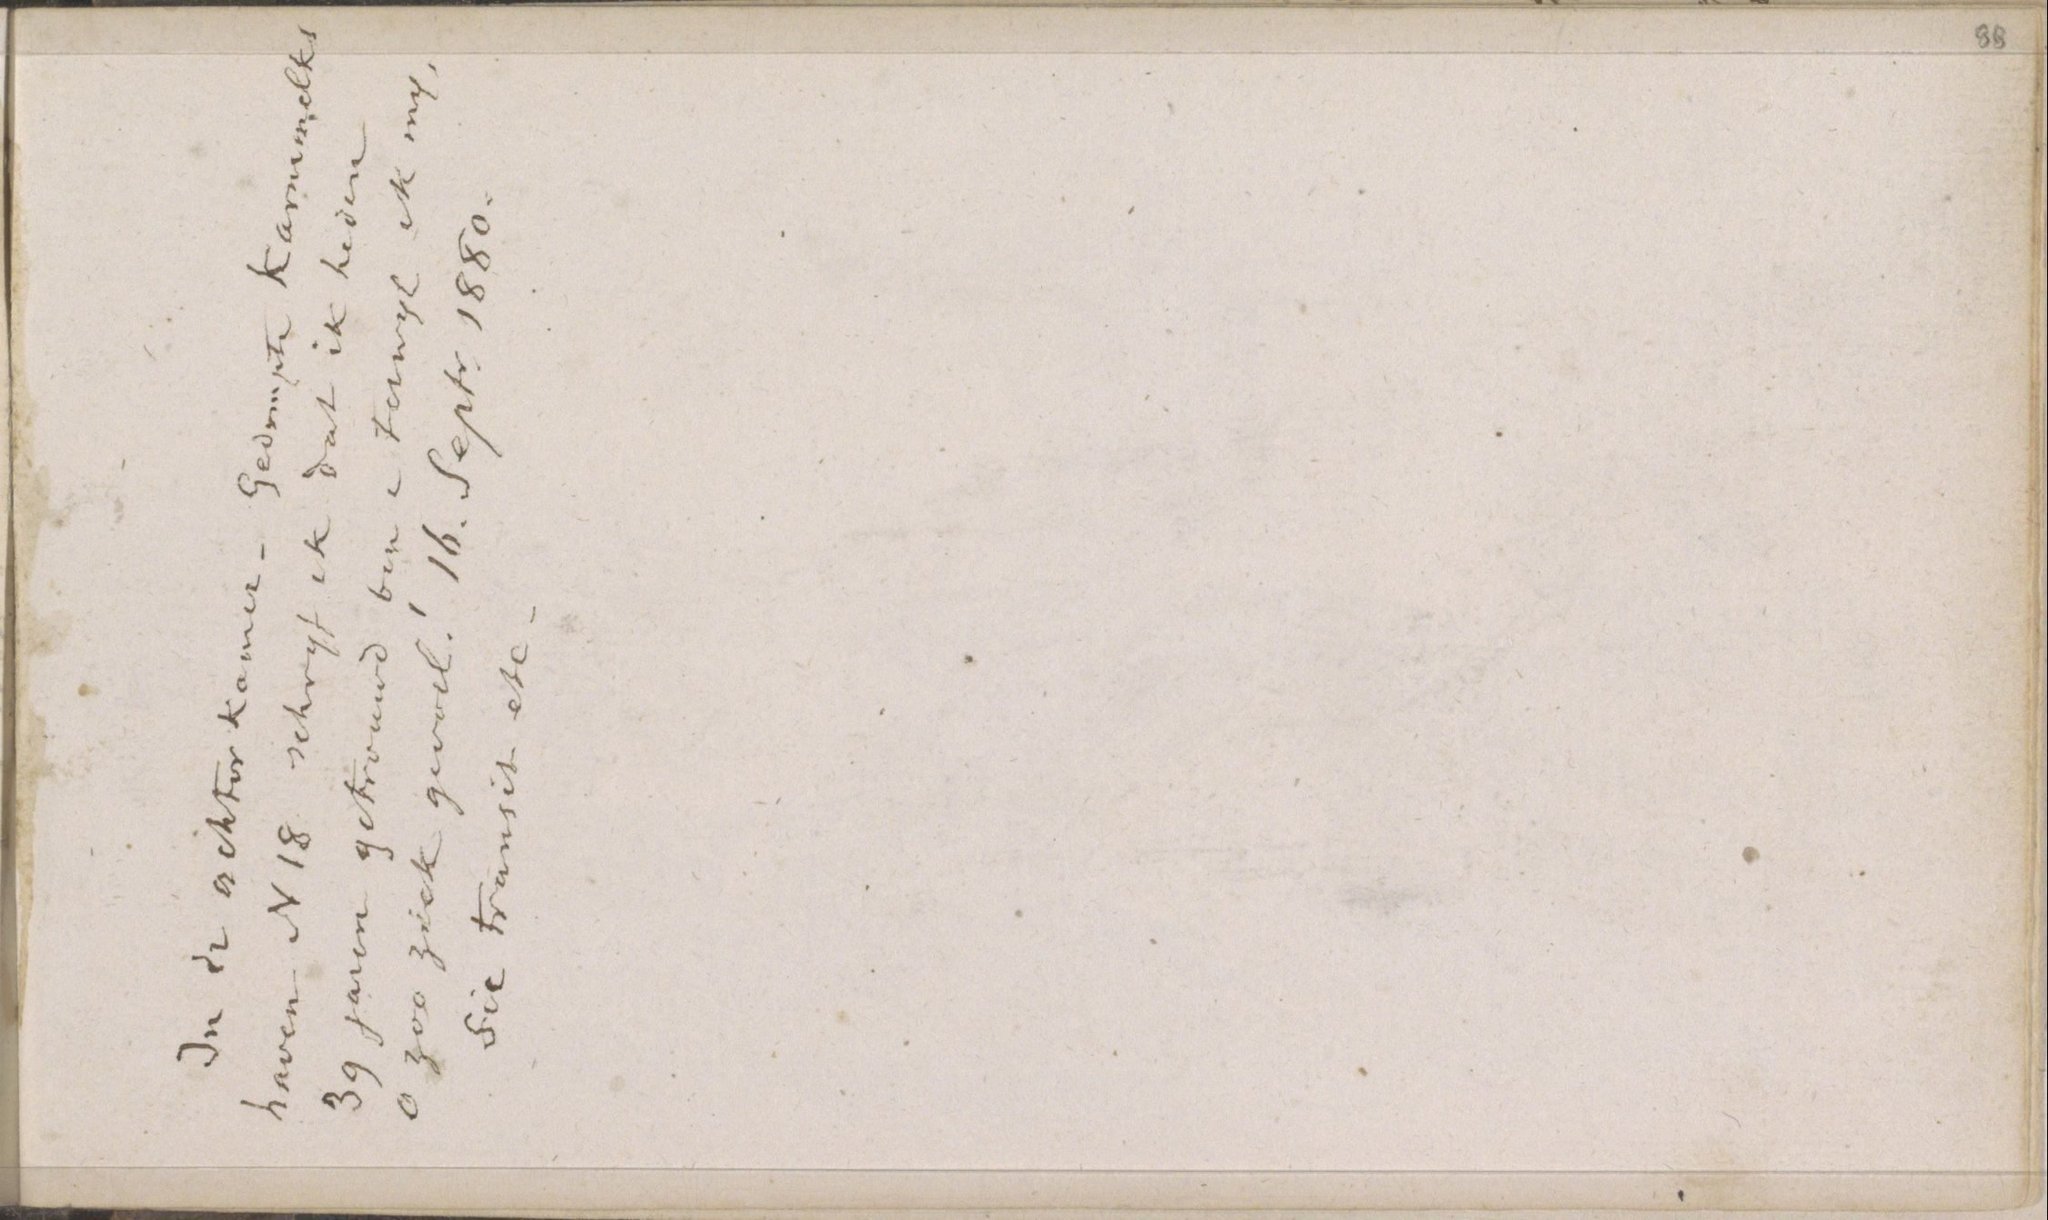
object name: sketchbook leaf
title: Notitie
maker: johannes tavenraat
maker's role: draughtsman, painter, print maker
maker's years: 1809-1881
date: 1809-1880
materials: ink, paper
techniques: pen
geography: rotterdam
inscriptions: date and inscription: ‘In de achterkamer - Gedempte Karnemelks/ haven N18 schrijf ik dat ik heden/ 39 jaren getrouwd ben & terwijl ik mij/ o zoo ziek gevoel! 16 Sept. 1880/ sic transit etc-’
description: Blad 88 recto uit een schetsboek met 98 bladen.